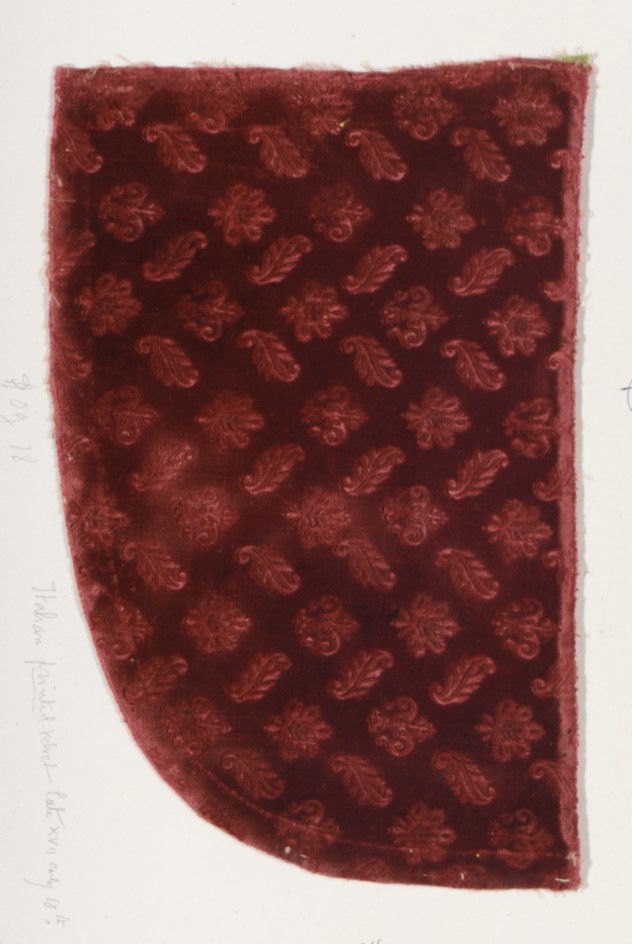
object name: fragment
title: Fragment of stamped velvet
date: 1667-1800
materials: silk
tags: flowers